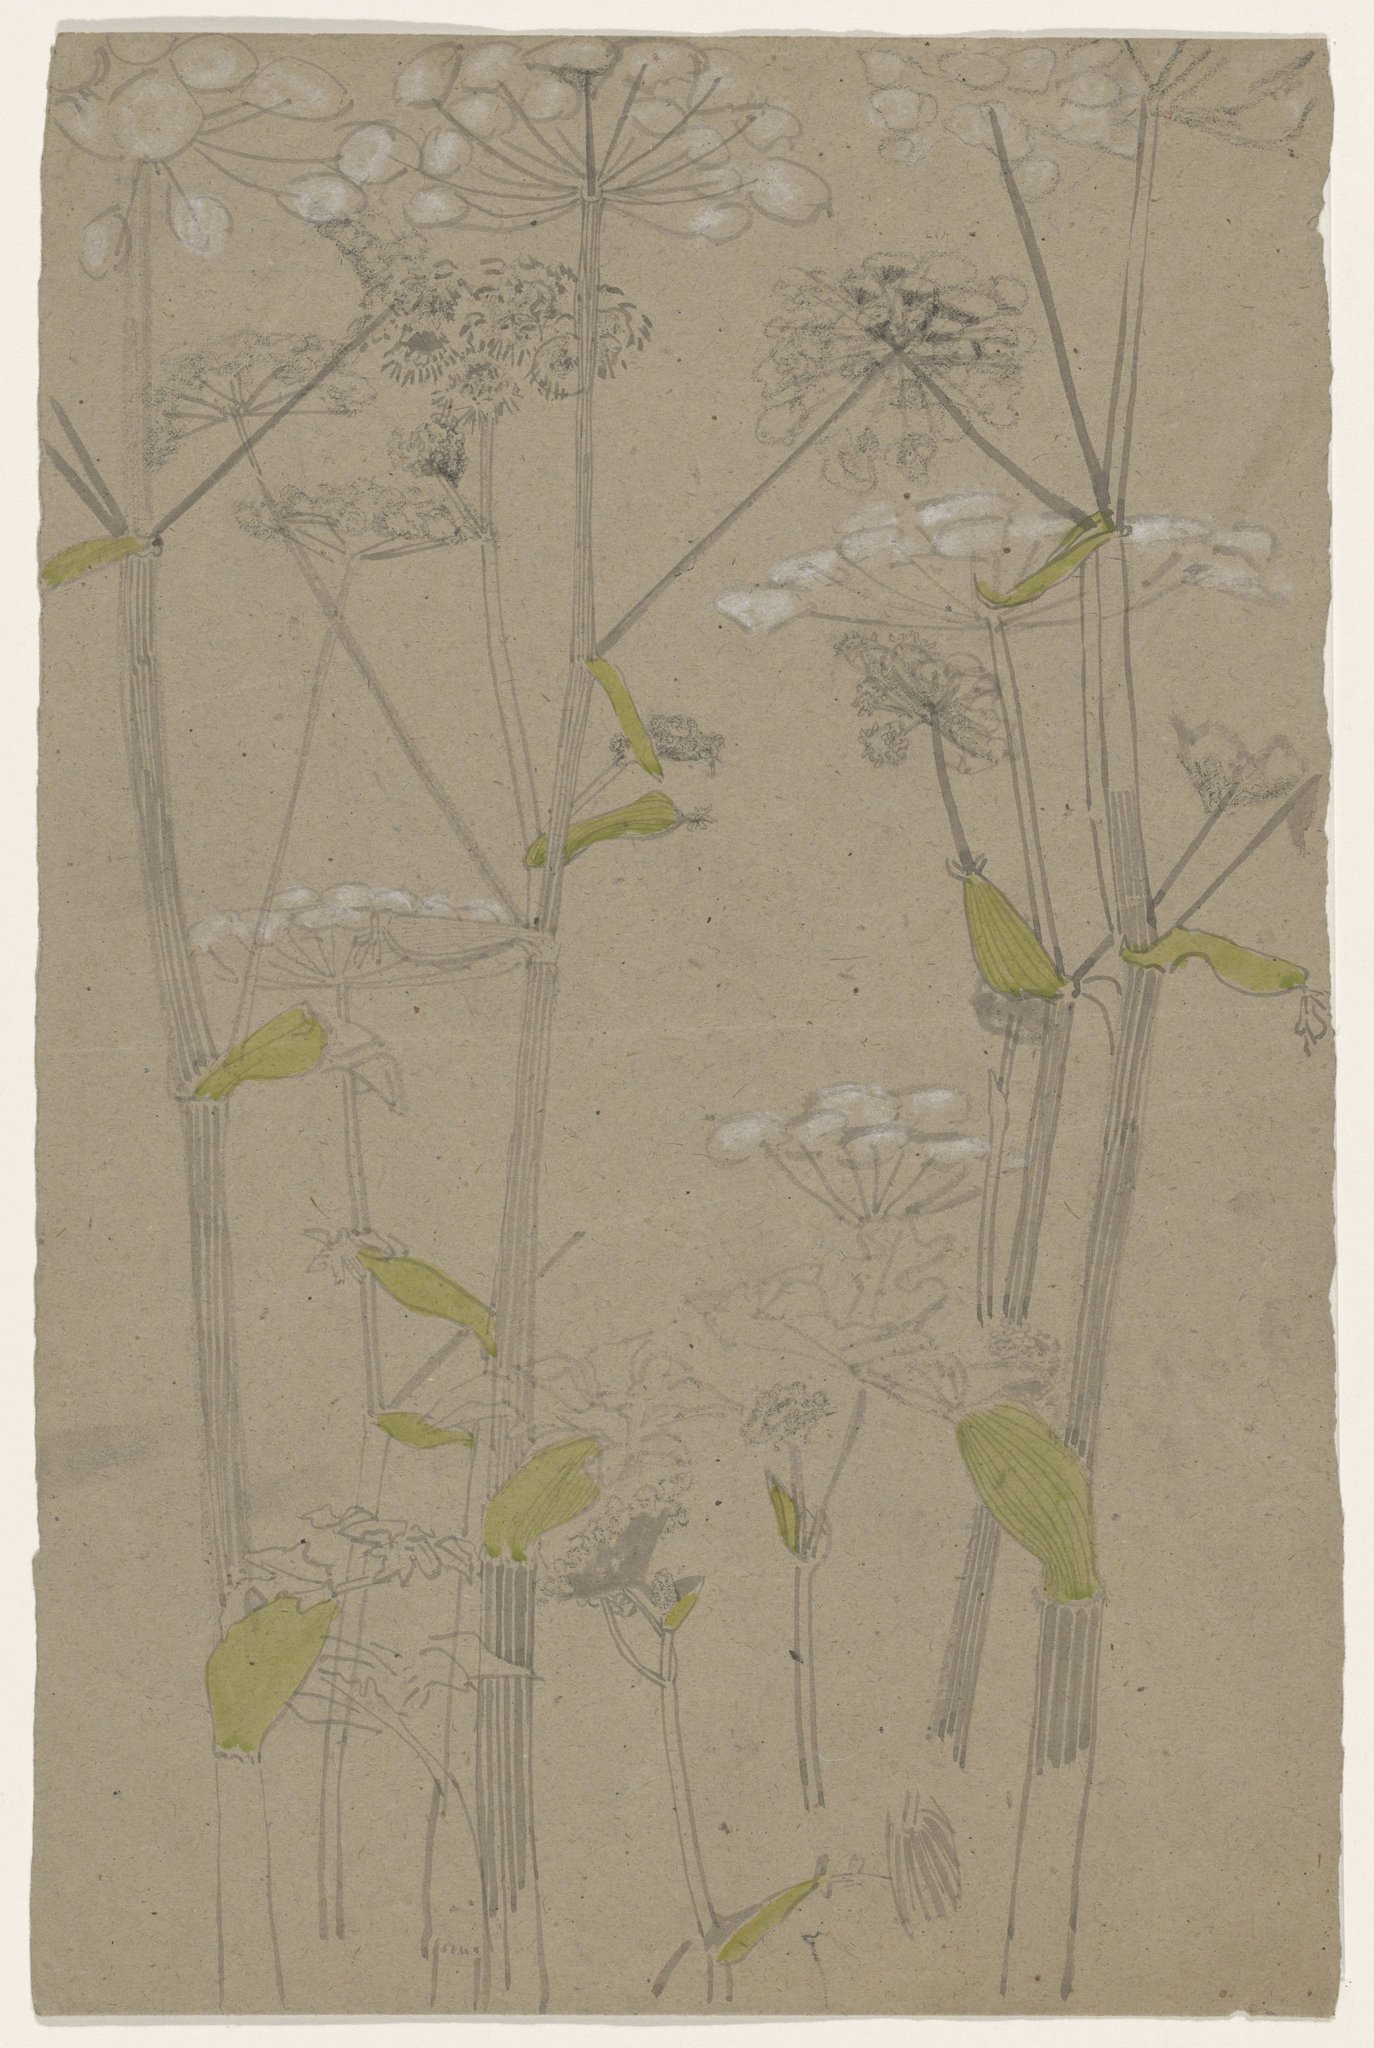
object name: drawing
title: Studies of Plants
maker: carel adolph lion cachet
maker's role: draughtsman, print maker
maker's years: 1864-1945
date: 1874-1945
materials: chalk, paper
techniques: brush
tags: flowers